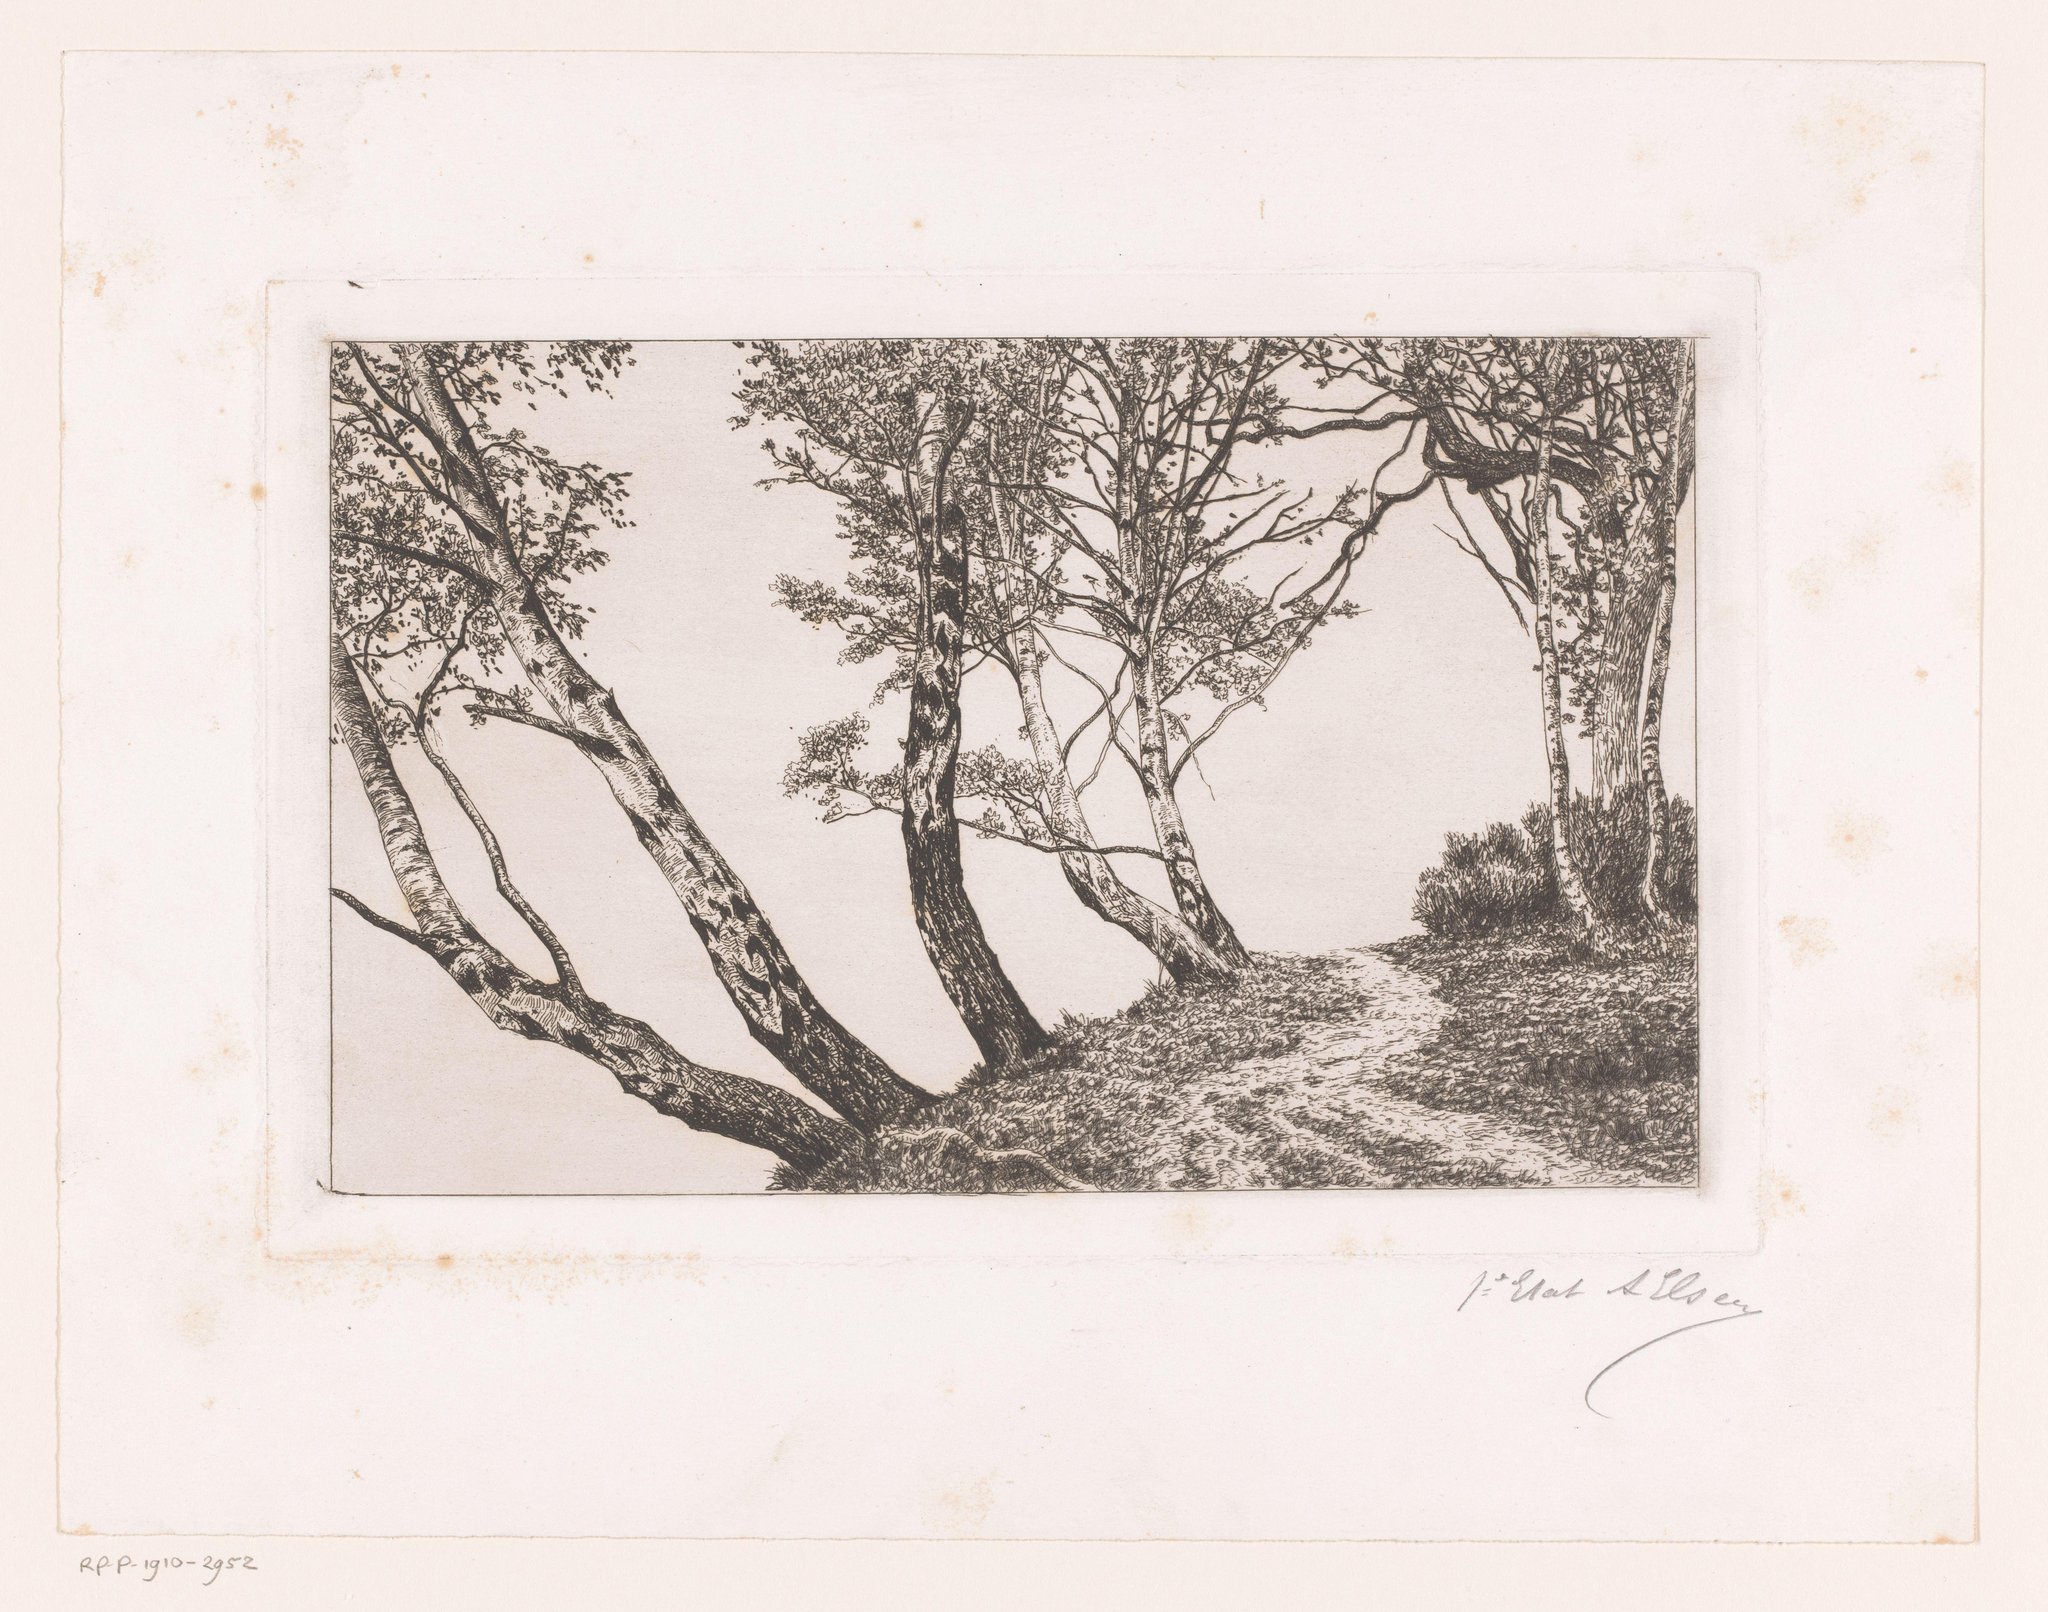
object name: print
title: Landschap met berken langs een oever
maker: alfred elsen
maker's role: painter, print maker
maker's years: 1850-1914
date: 1860-1910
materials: paper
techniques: etching, intaglio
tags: forest path or lane, trees: birch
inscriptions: inscription: ‘1e Etat’, collector's mark: Lugt 2228